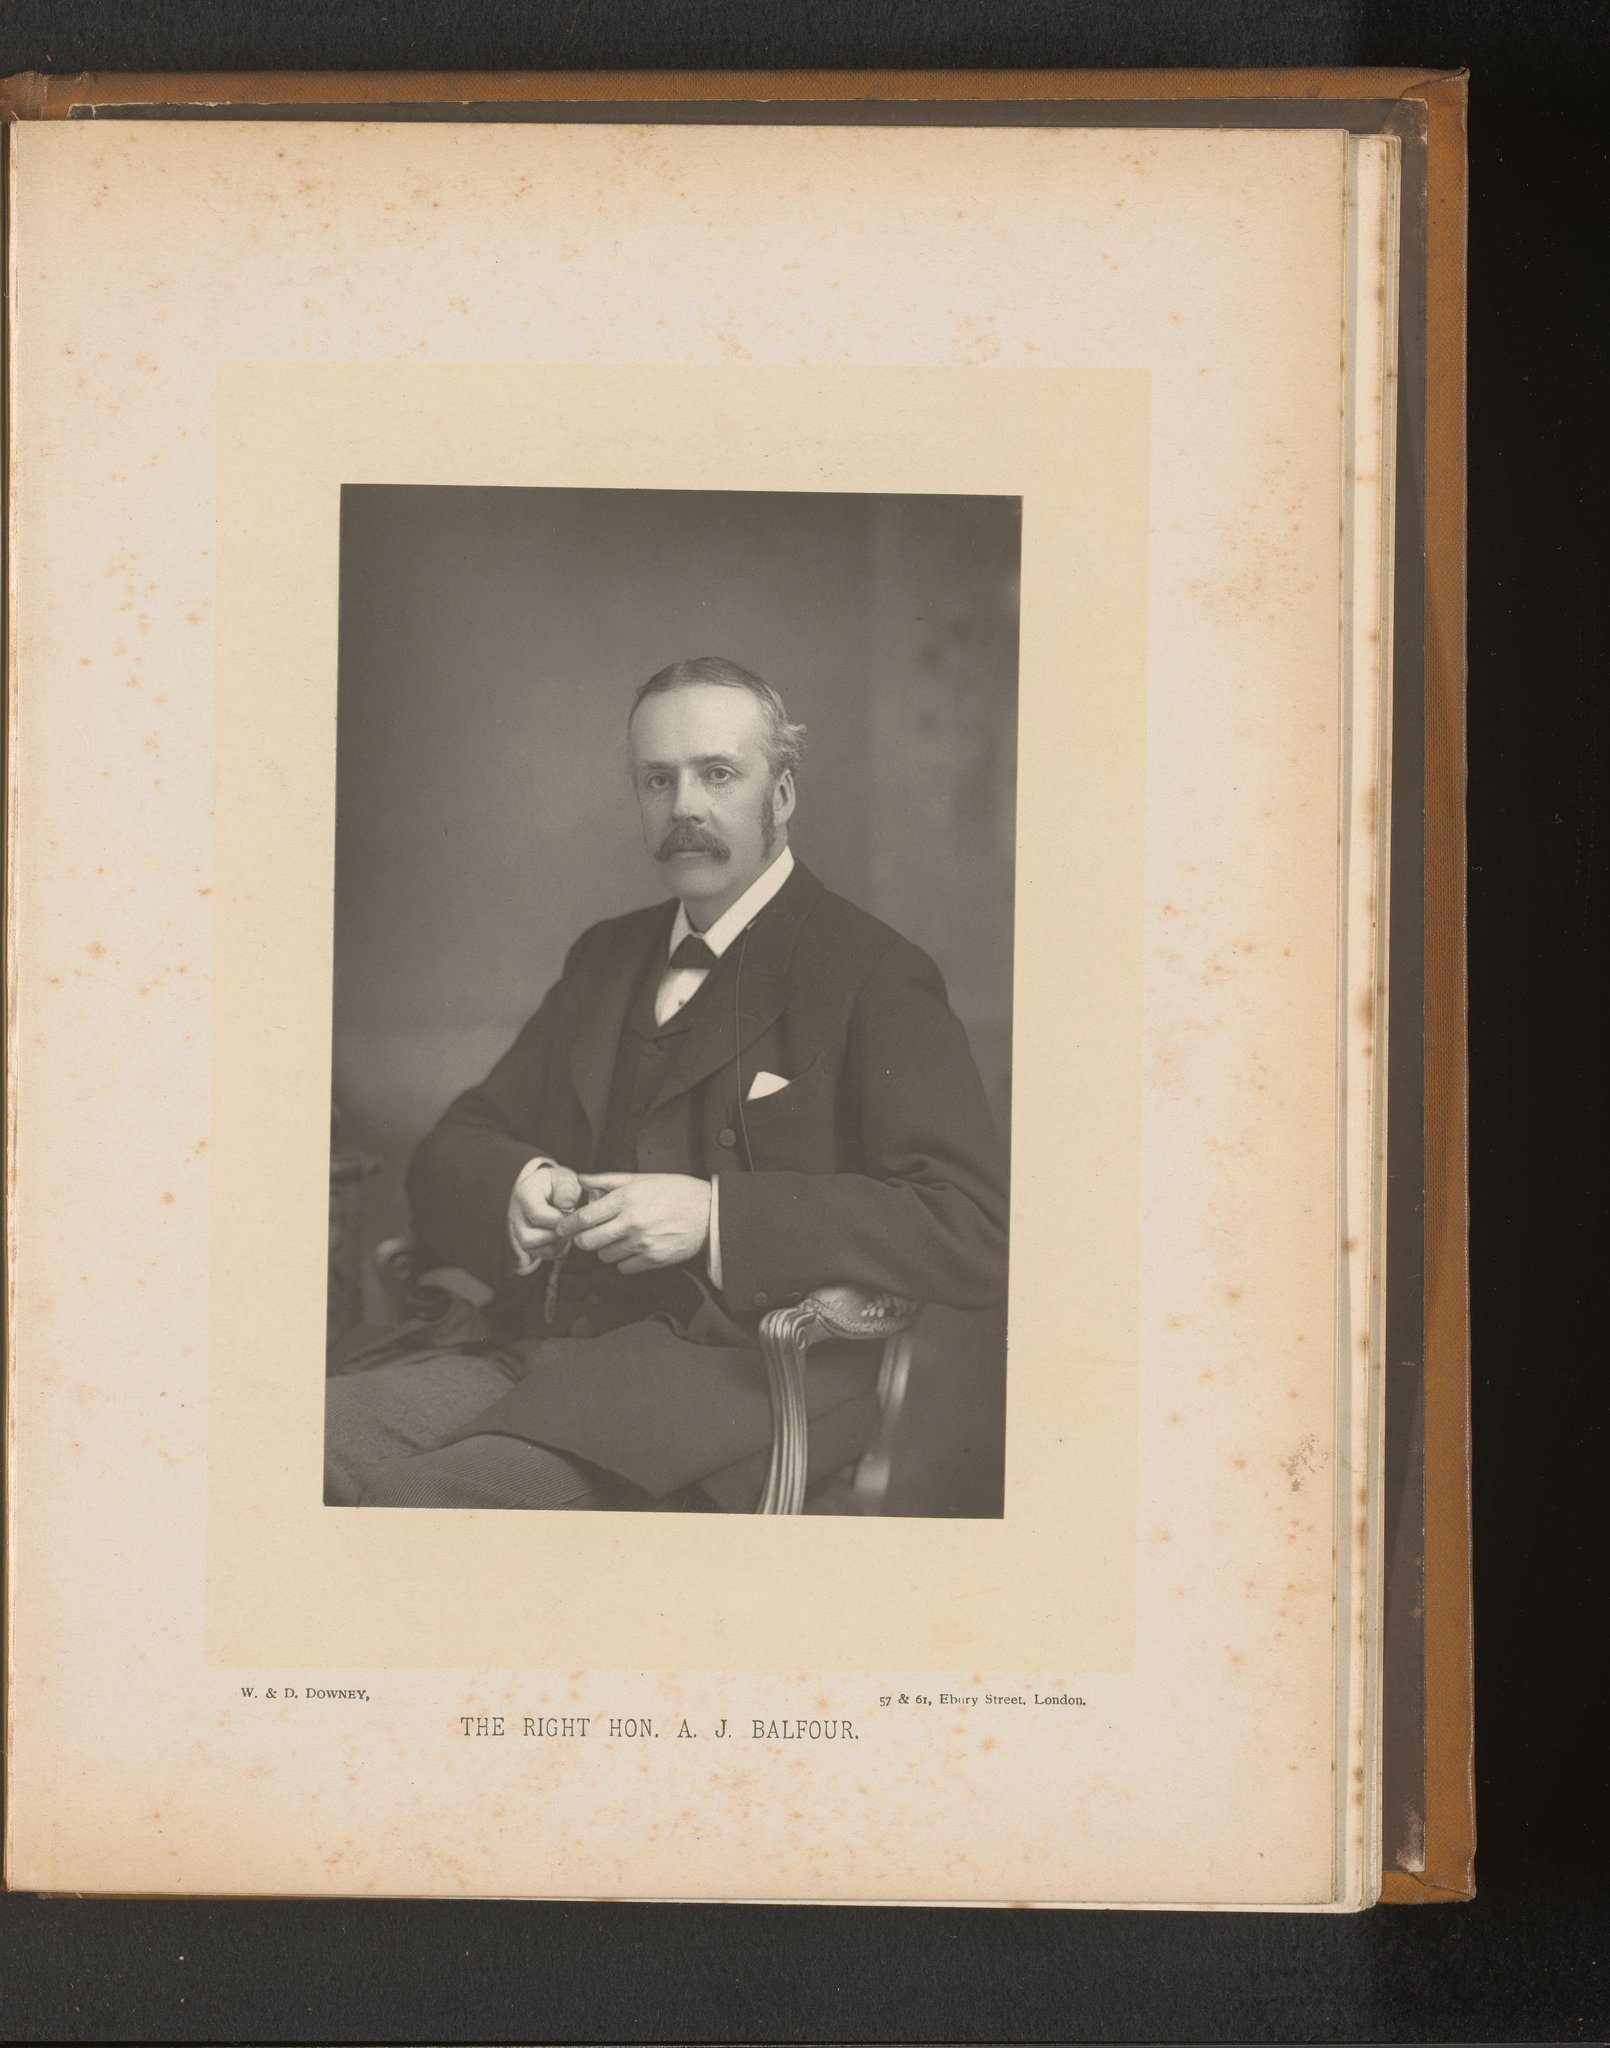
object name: photomechanical print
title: The right Hon. A.J. Balfour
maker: Anonymous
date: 1884-1894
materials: paper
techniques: woodburytype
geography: london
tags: politician, minister ~ government, politician, e.g. party leader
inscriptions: inscription: ‘57 & 61, Elbury Street, London.’